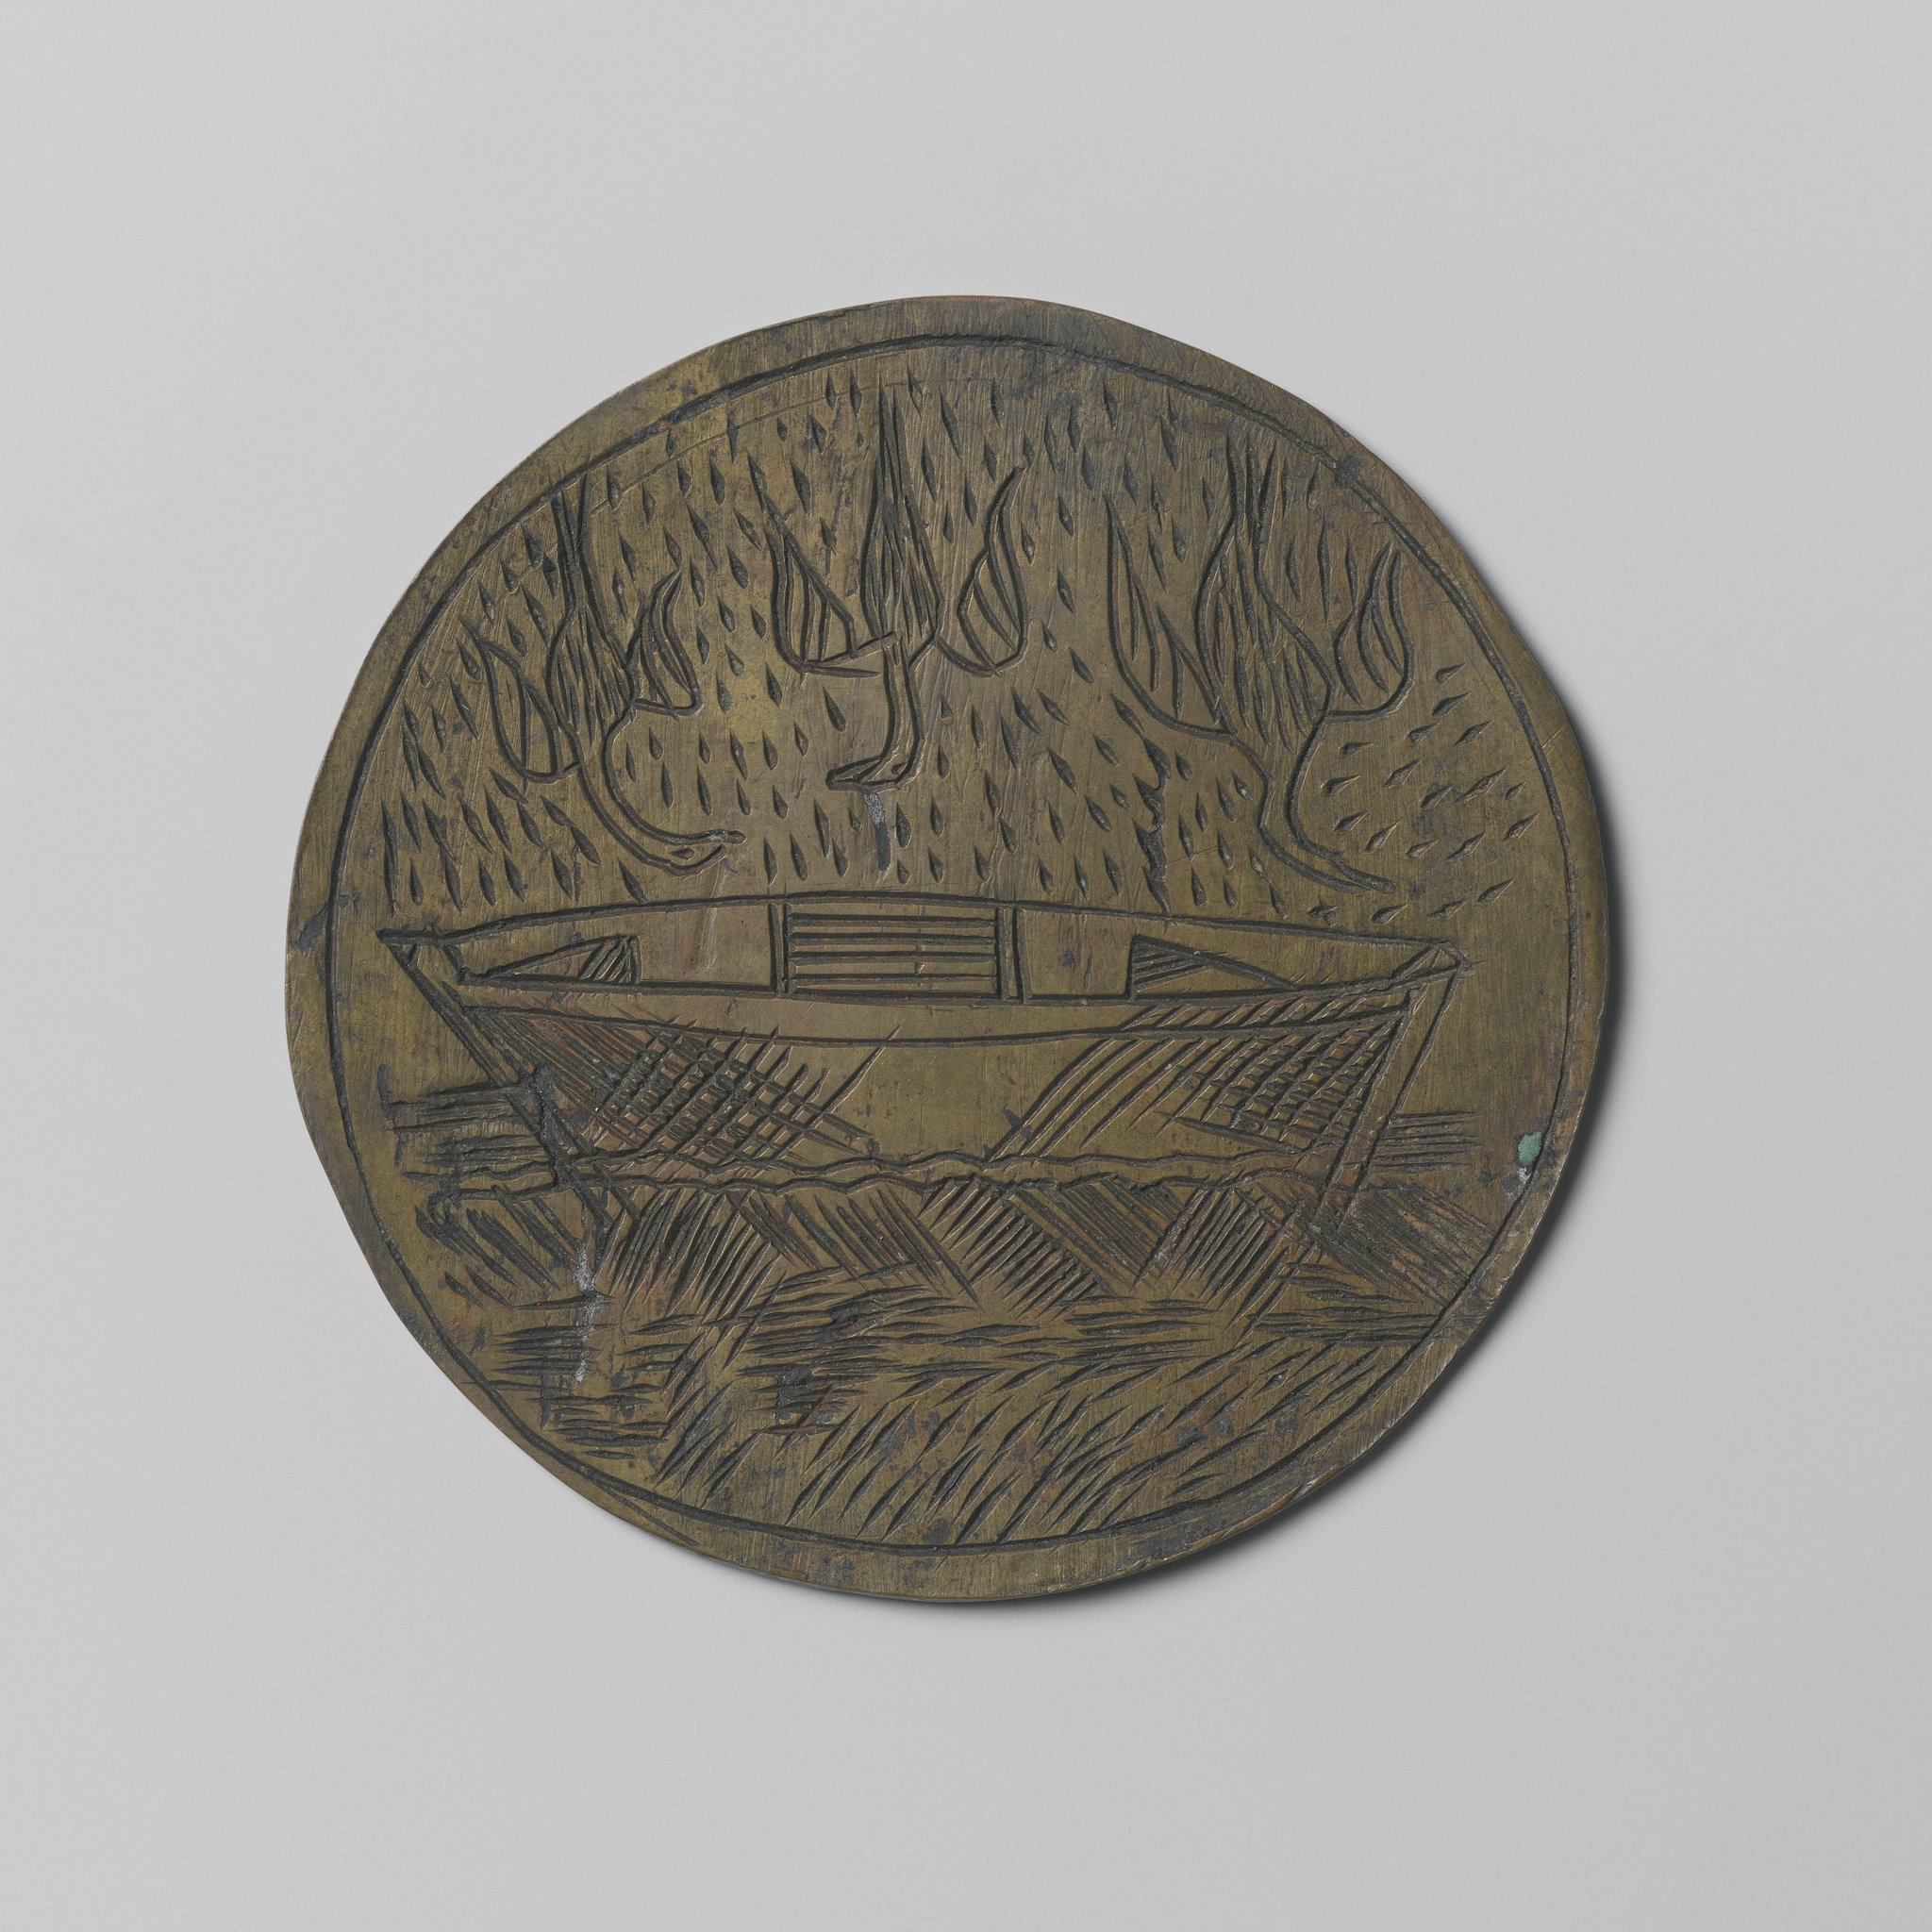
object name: medal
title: Vlotschuitvoerdersgilde van Amsterdam, gildepenning van Flooris de Jong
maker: Anonymous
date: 1770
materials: brass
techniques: engraving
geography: amsterdam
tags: amsterdam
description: Messing penning. Voorzijde: schuit; daarboven drie naar beneden duikende vogels. Keerzijde: opschrift boven jaartal